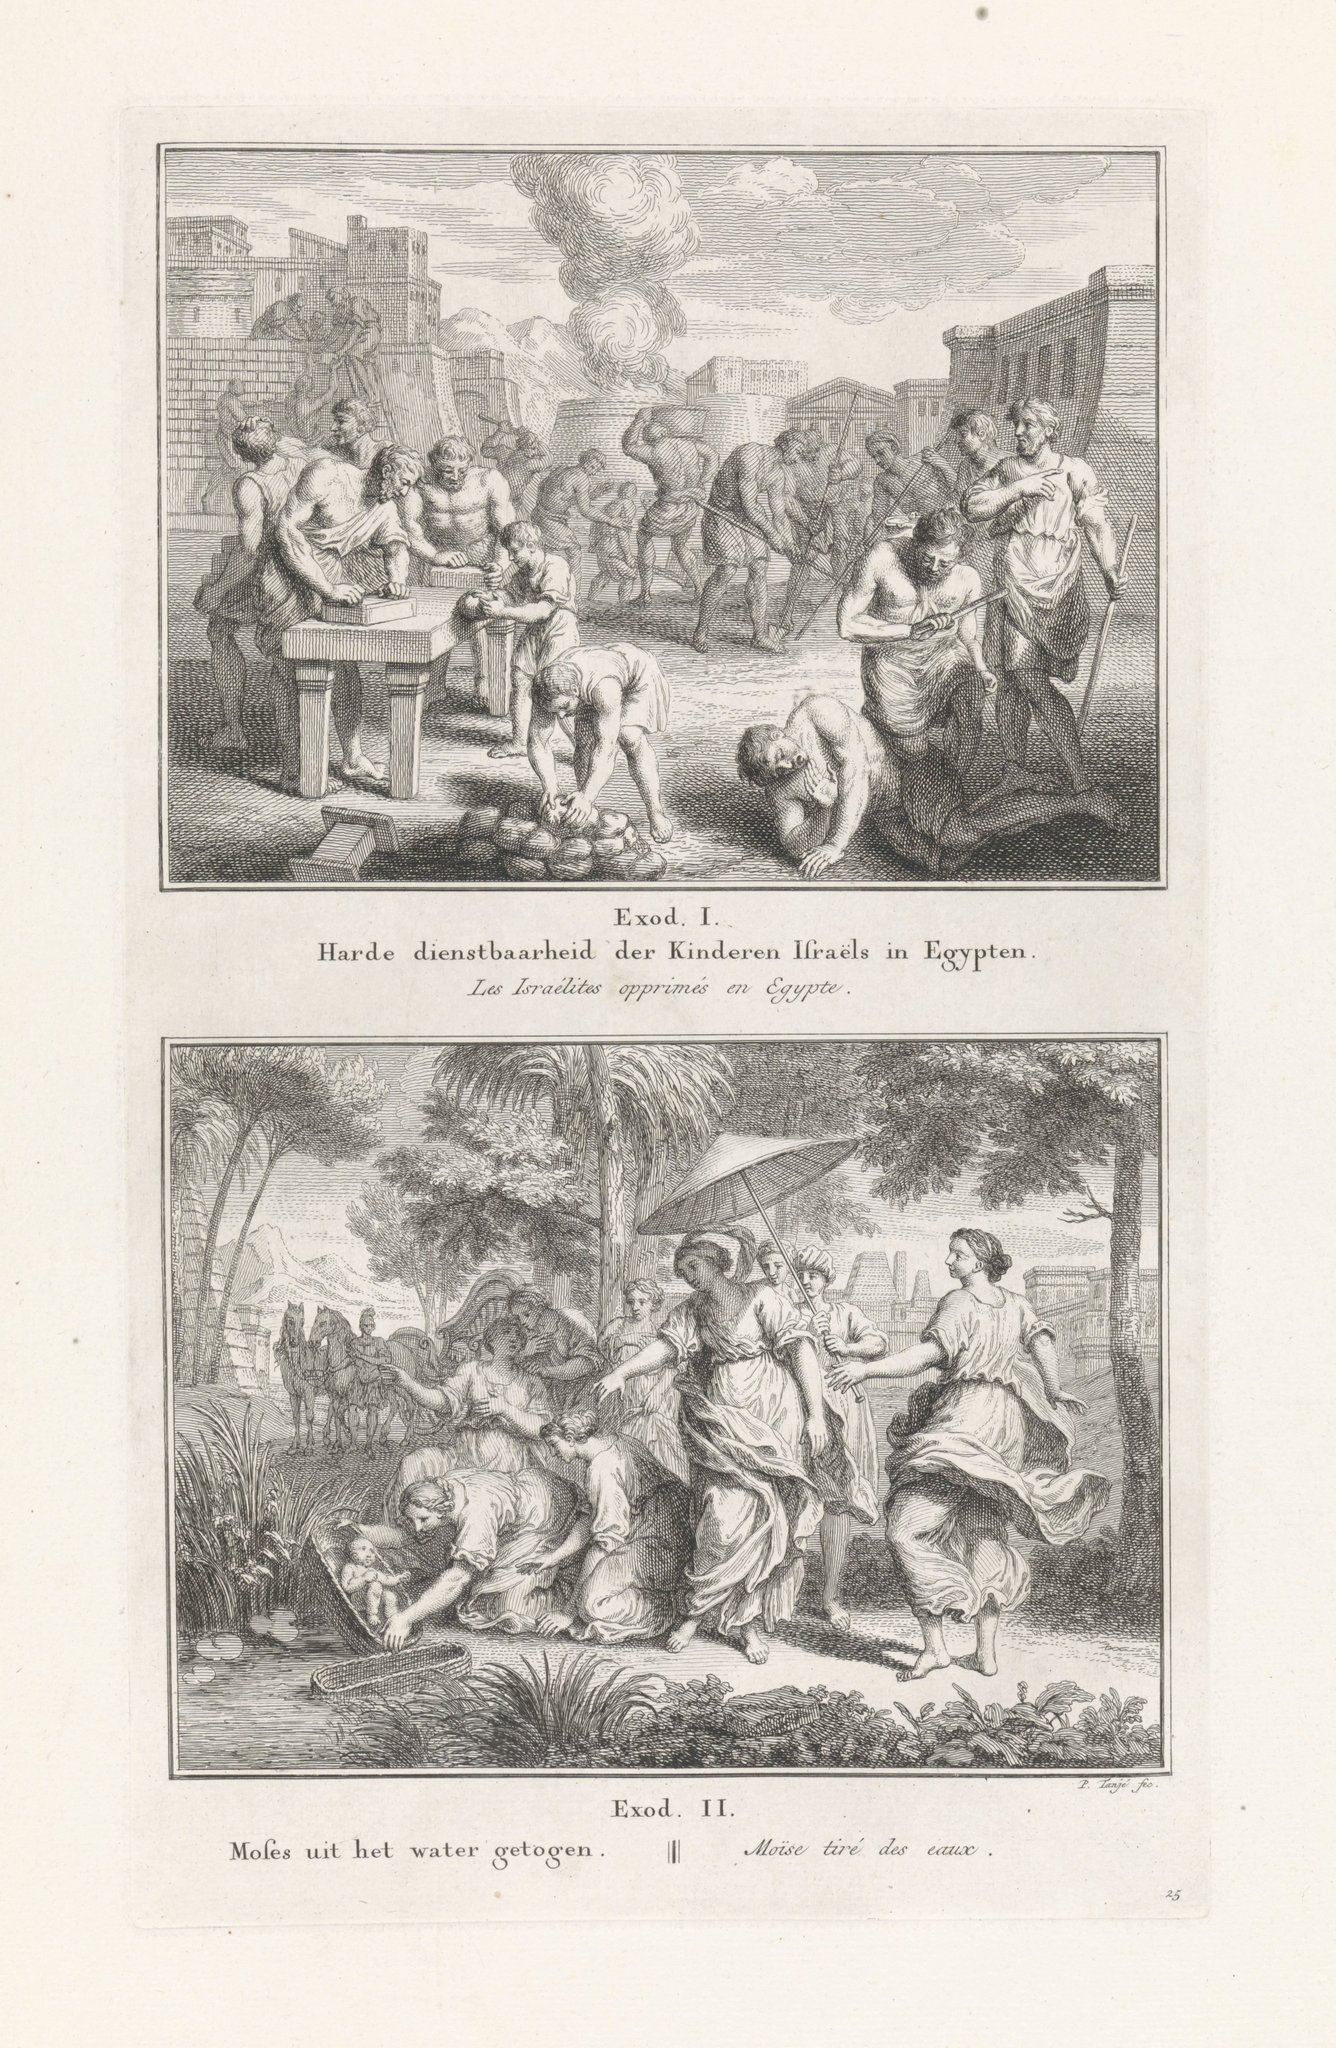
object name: book illustration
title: De Israëlieten in Egypte onderdrukt / Mozes wordt gevonden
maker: pieter tanjé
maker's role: draughtsman, print maker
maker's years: 1706-1761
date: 1716-1761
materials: paper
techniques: engraving, etching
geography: amsterdam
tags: the israelites are forced to hard labour ~ exodus, moses is pulled out of the water by the servants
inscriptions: collector's mark: Lugt 3937, collector's mark: Lugt 2233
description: Prent mogelijk gebruikt in: Hamelsveld, Ysbrand van. De gewigtigste geschiedenissen des Bybels, afgebeeld in twee honderd twee en vĳftig printverbeeldingen (...) met eene zaaklĳke uitbreiding opgehelderd. Amsterdam: Jan de Groot, Gerrit Warnars, Petrus van Hengst, Dordrecht: Abraham Blussé, Pieter Blussé, Leiden: Samuel Luchtmans (III), Johannes Luchtmans, Harlingen: Volkert van der Plaats, 1791.